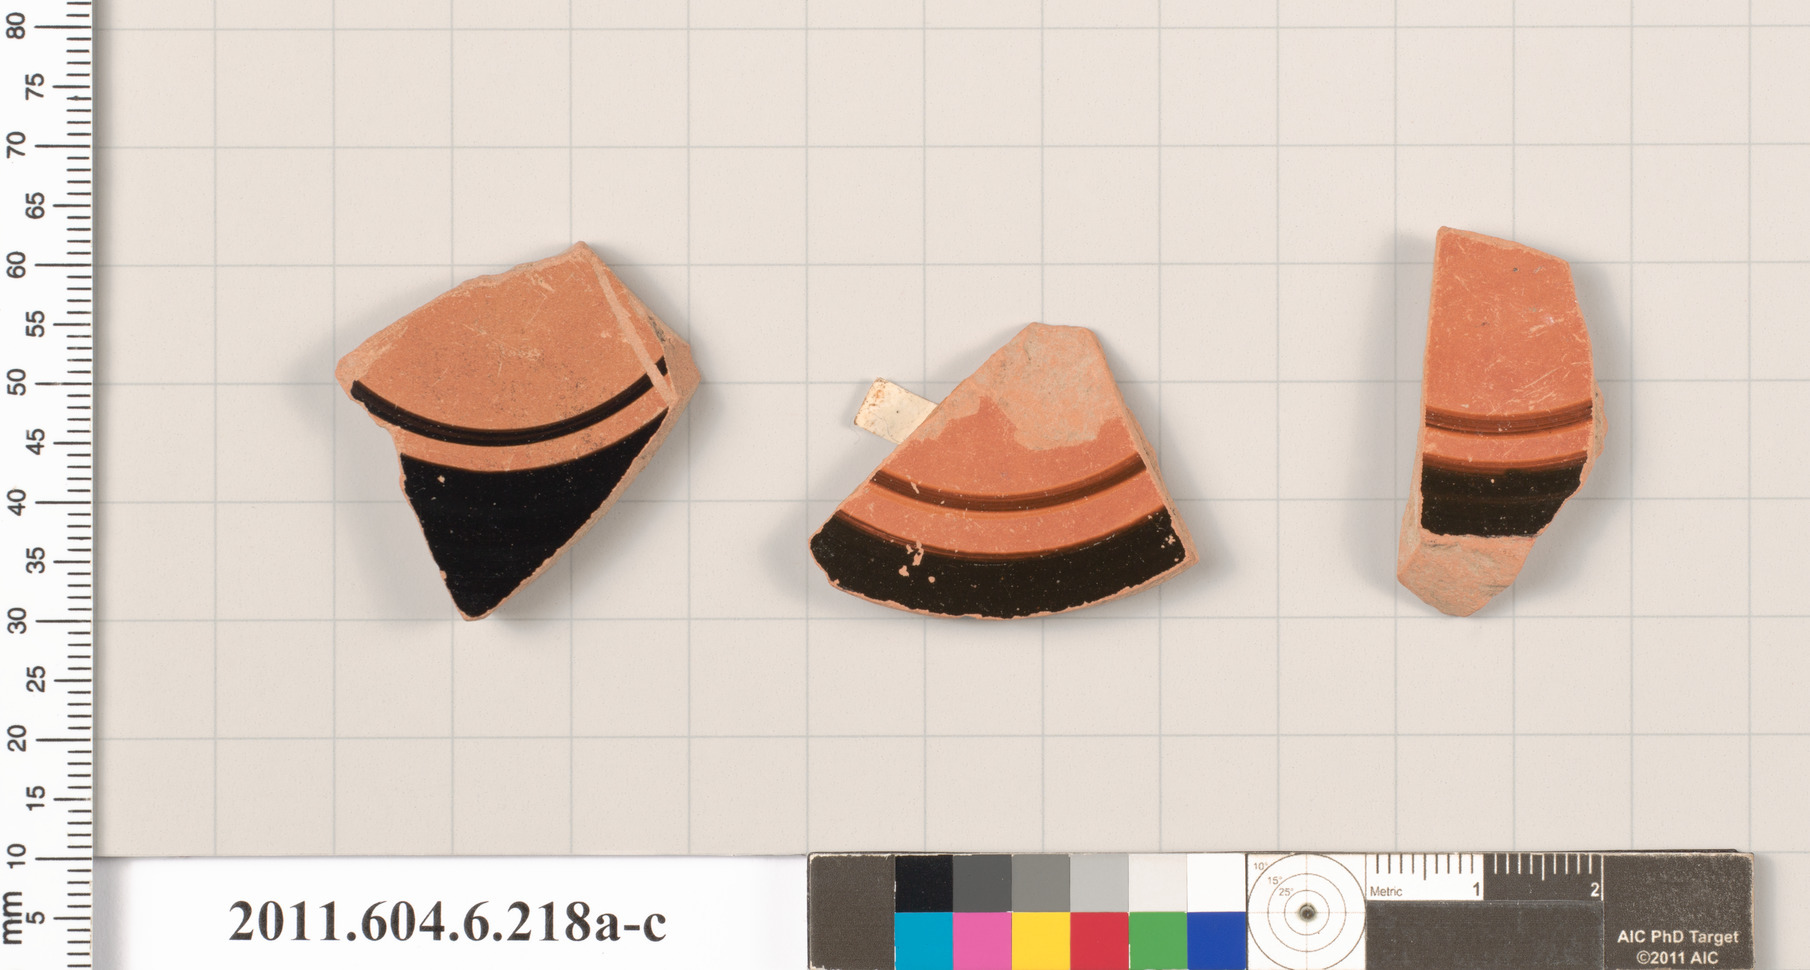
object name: undetermined open shape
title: Terracotta fragments of open shapes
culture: greek, attic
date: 600-401 BCE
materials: terracotta